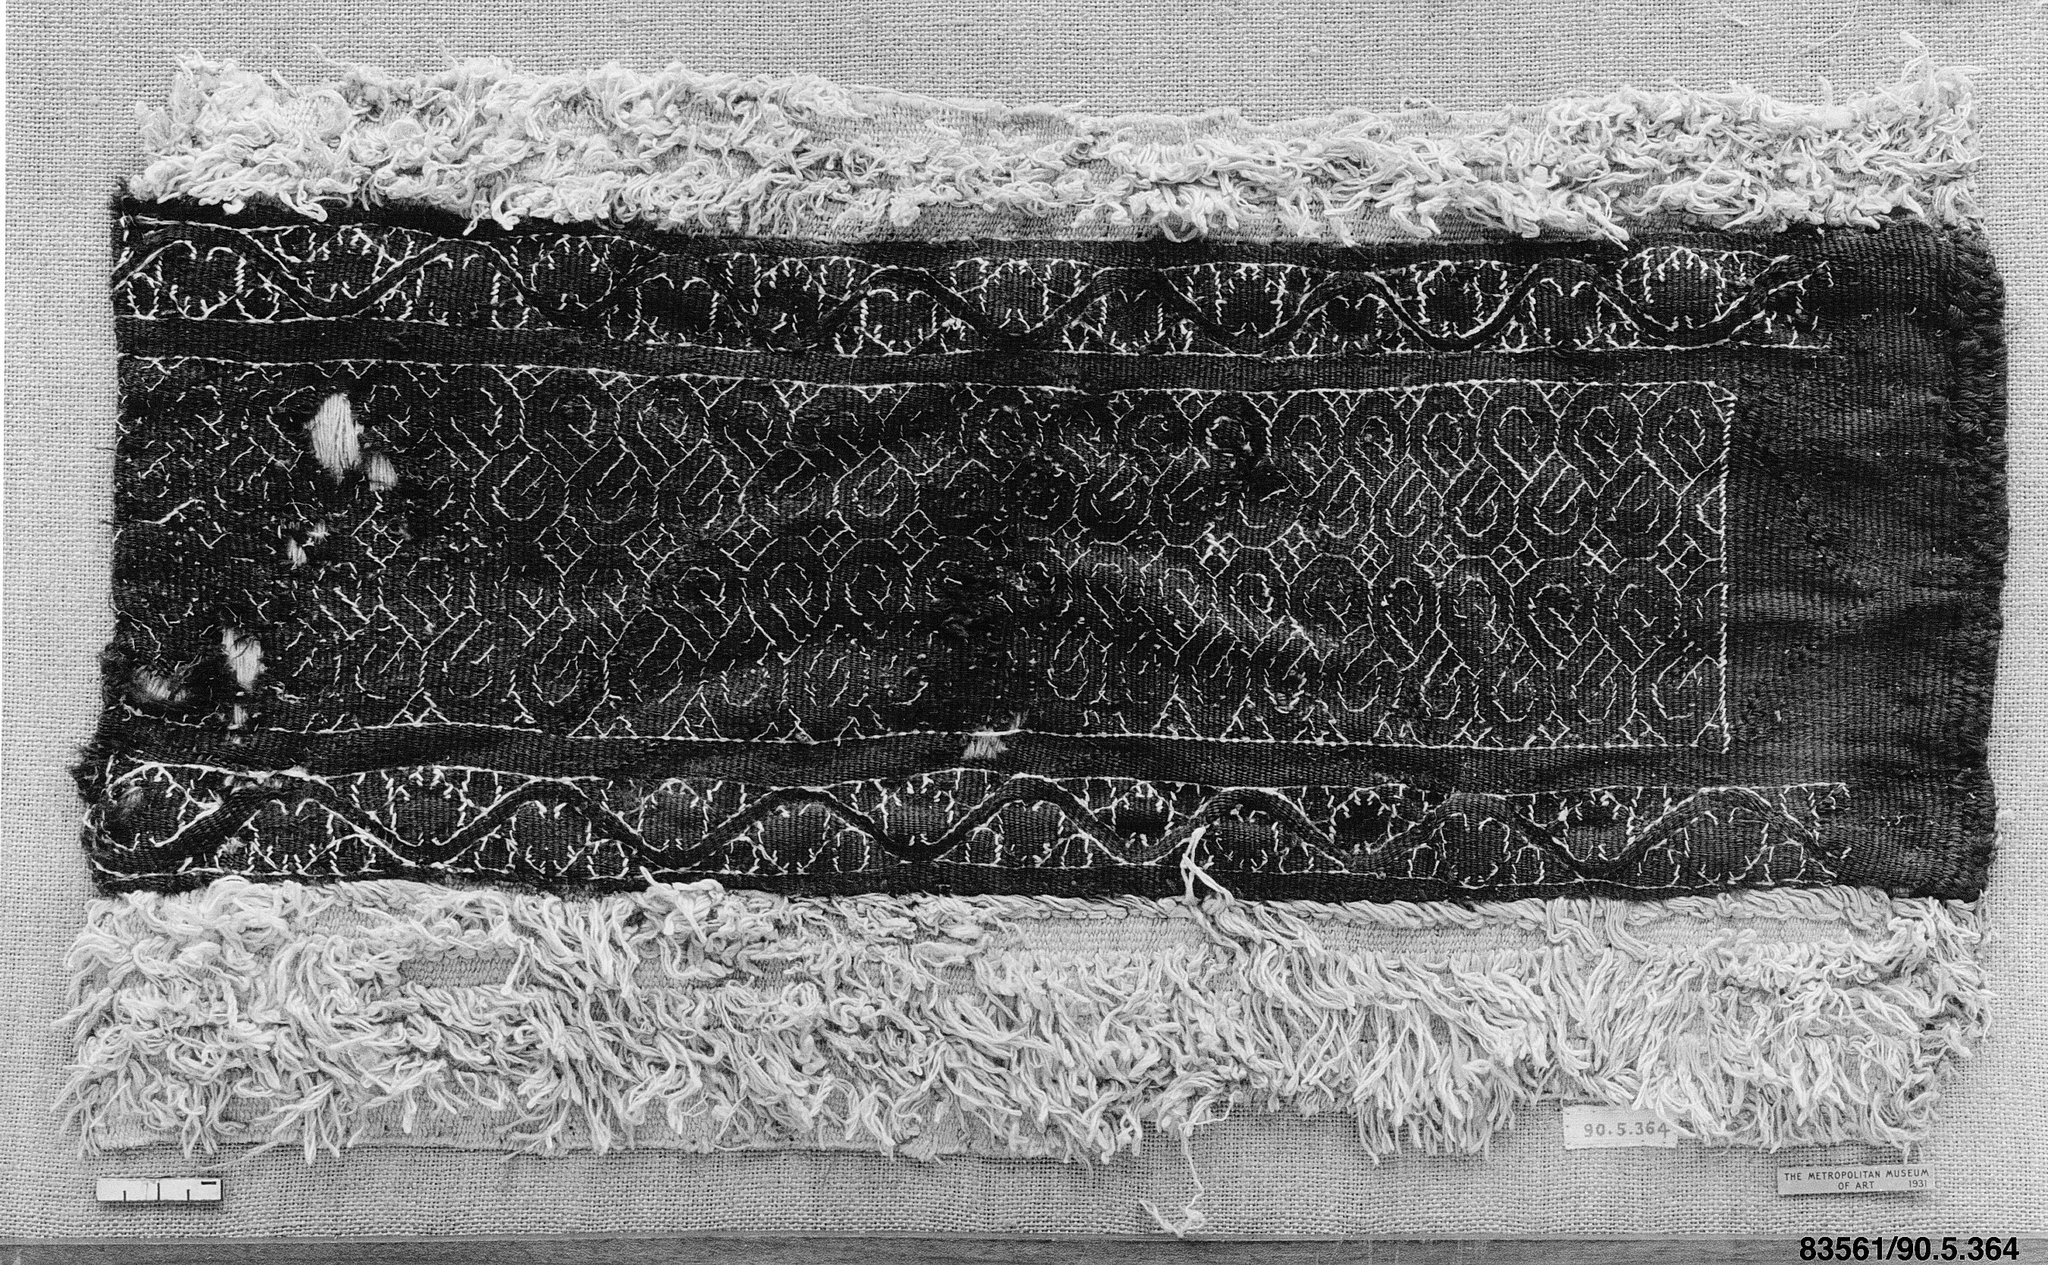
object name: textile fragment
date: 201-400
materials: linen, wool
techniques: weave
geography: egypt